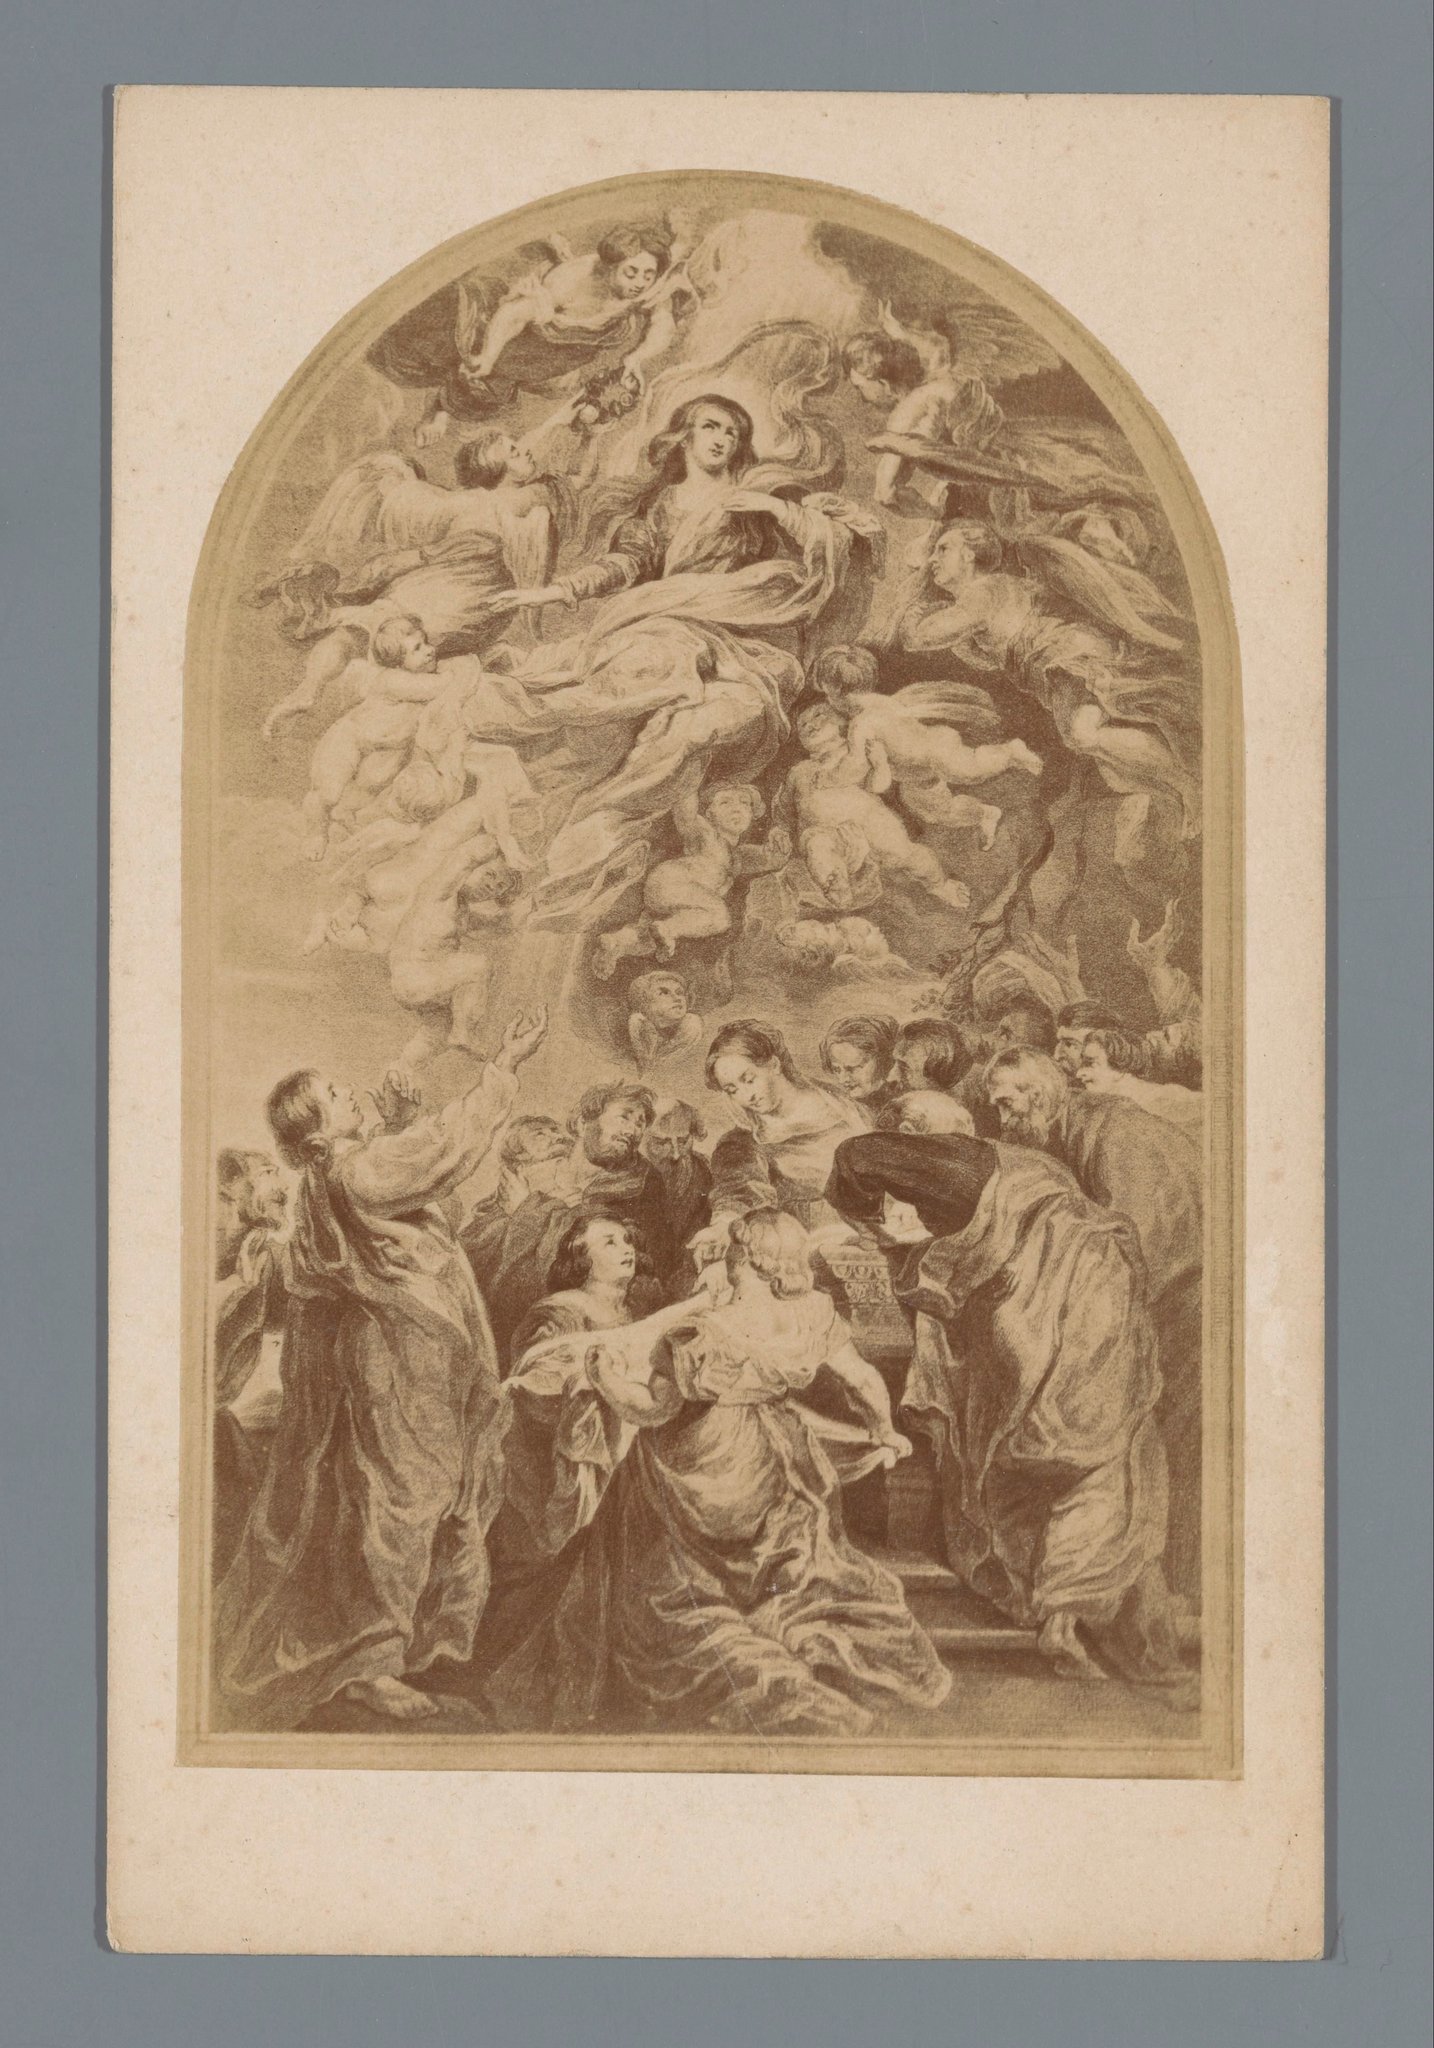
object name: reproduction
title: Fotoreproductie van Hemelvaart van Maria door Peter Paul Rubens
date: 1850-1900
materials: cardboard, photographic support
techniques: albumen print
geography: antwerp cathedral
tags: mary (without the christ-child), apotheosis (or ascension) of individuals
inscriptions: inscription: ‘Rubens/ L'assomption de la Vierge./ Cathedrale d'Anvers.’